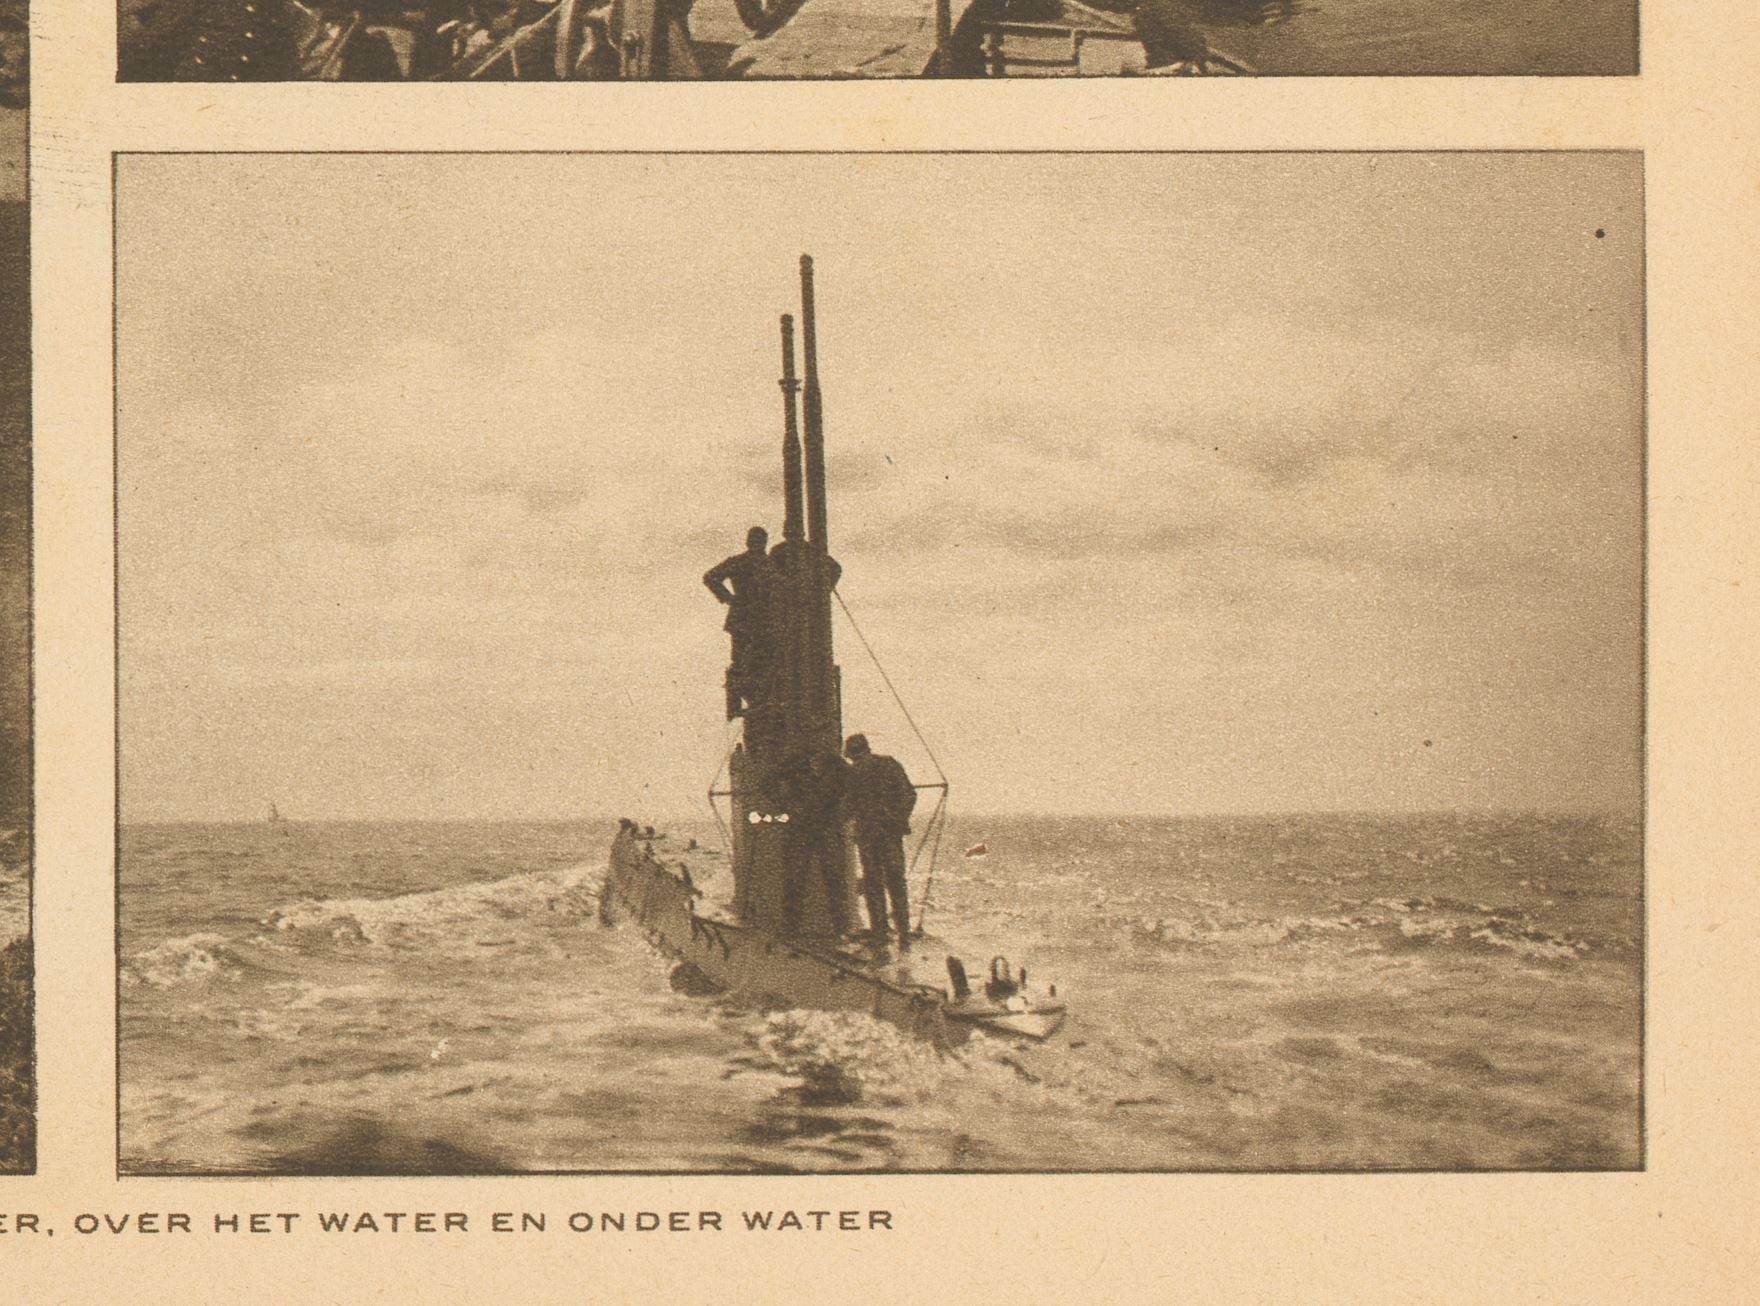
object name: album leaf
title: Onderzeeër op zee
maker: Anonymous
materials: paper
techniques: rotogravure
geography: netherlands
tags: submarine, sea (seascape), netherlands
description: Deze prent maakt deel uit van een album.